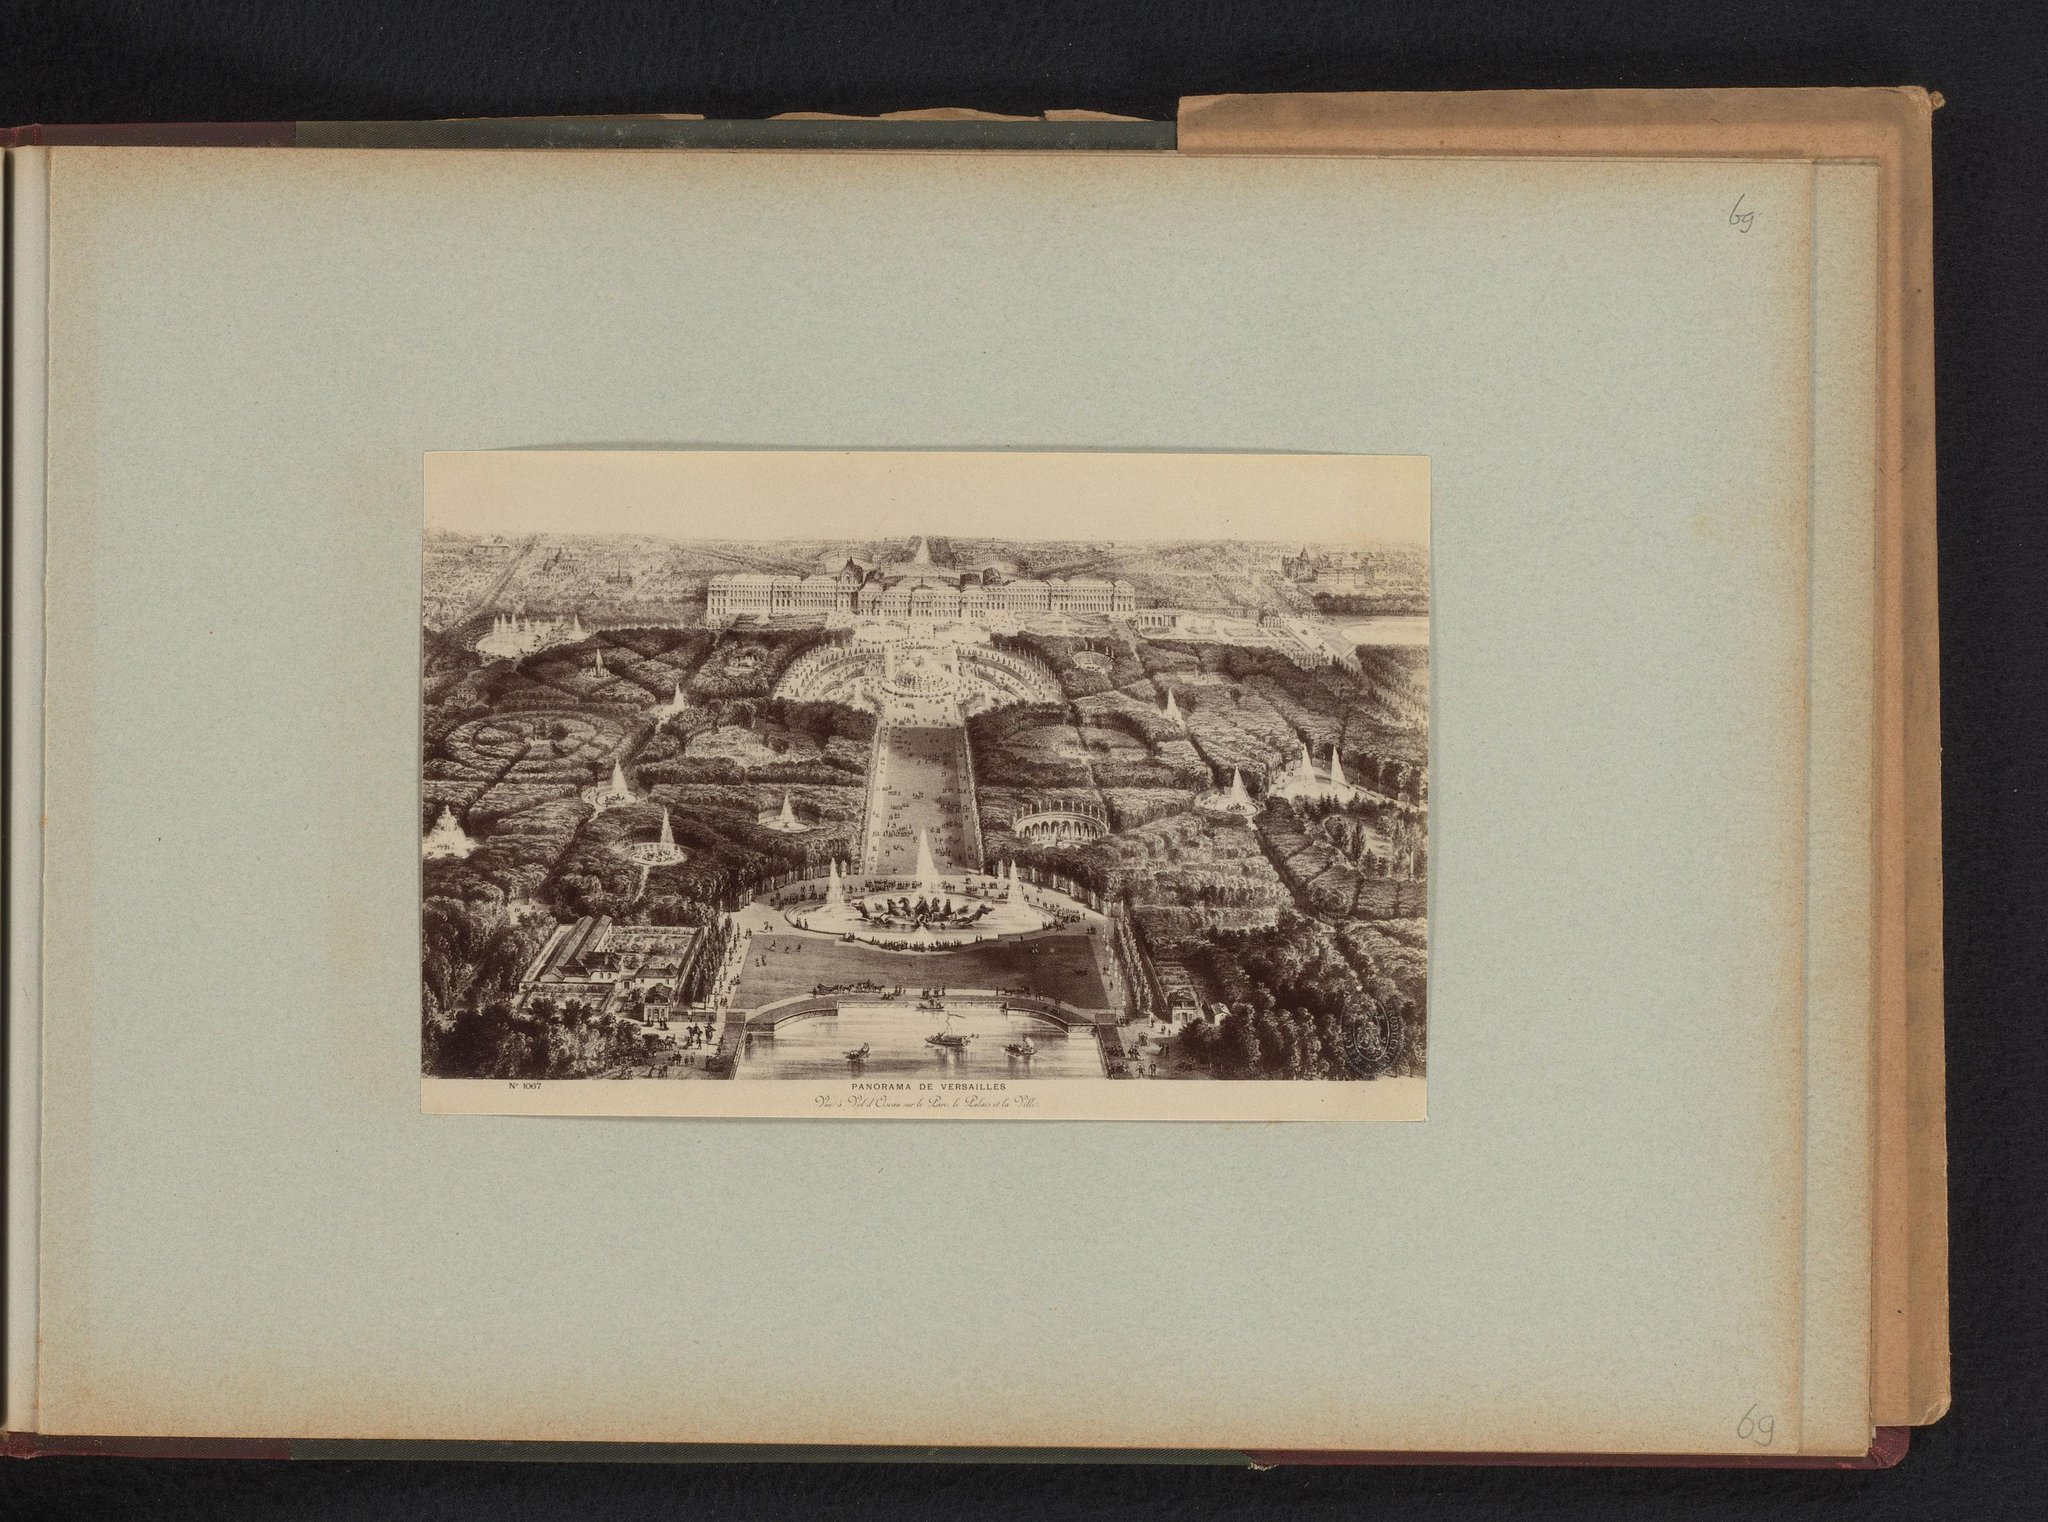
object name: album leaf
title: Fotoreproductie van een tekening vanuit vogelvluchtperspectief op het kasteel van Versailles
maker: Anonymous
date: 1851-1900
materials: paper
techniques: albumen print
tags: palace, french or architectonic garden; formal garden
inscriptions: inscription: ‘REPRODUCTION/ INTERDITE’, number: ‘No 1067’